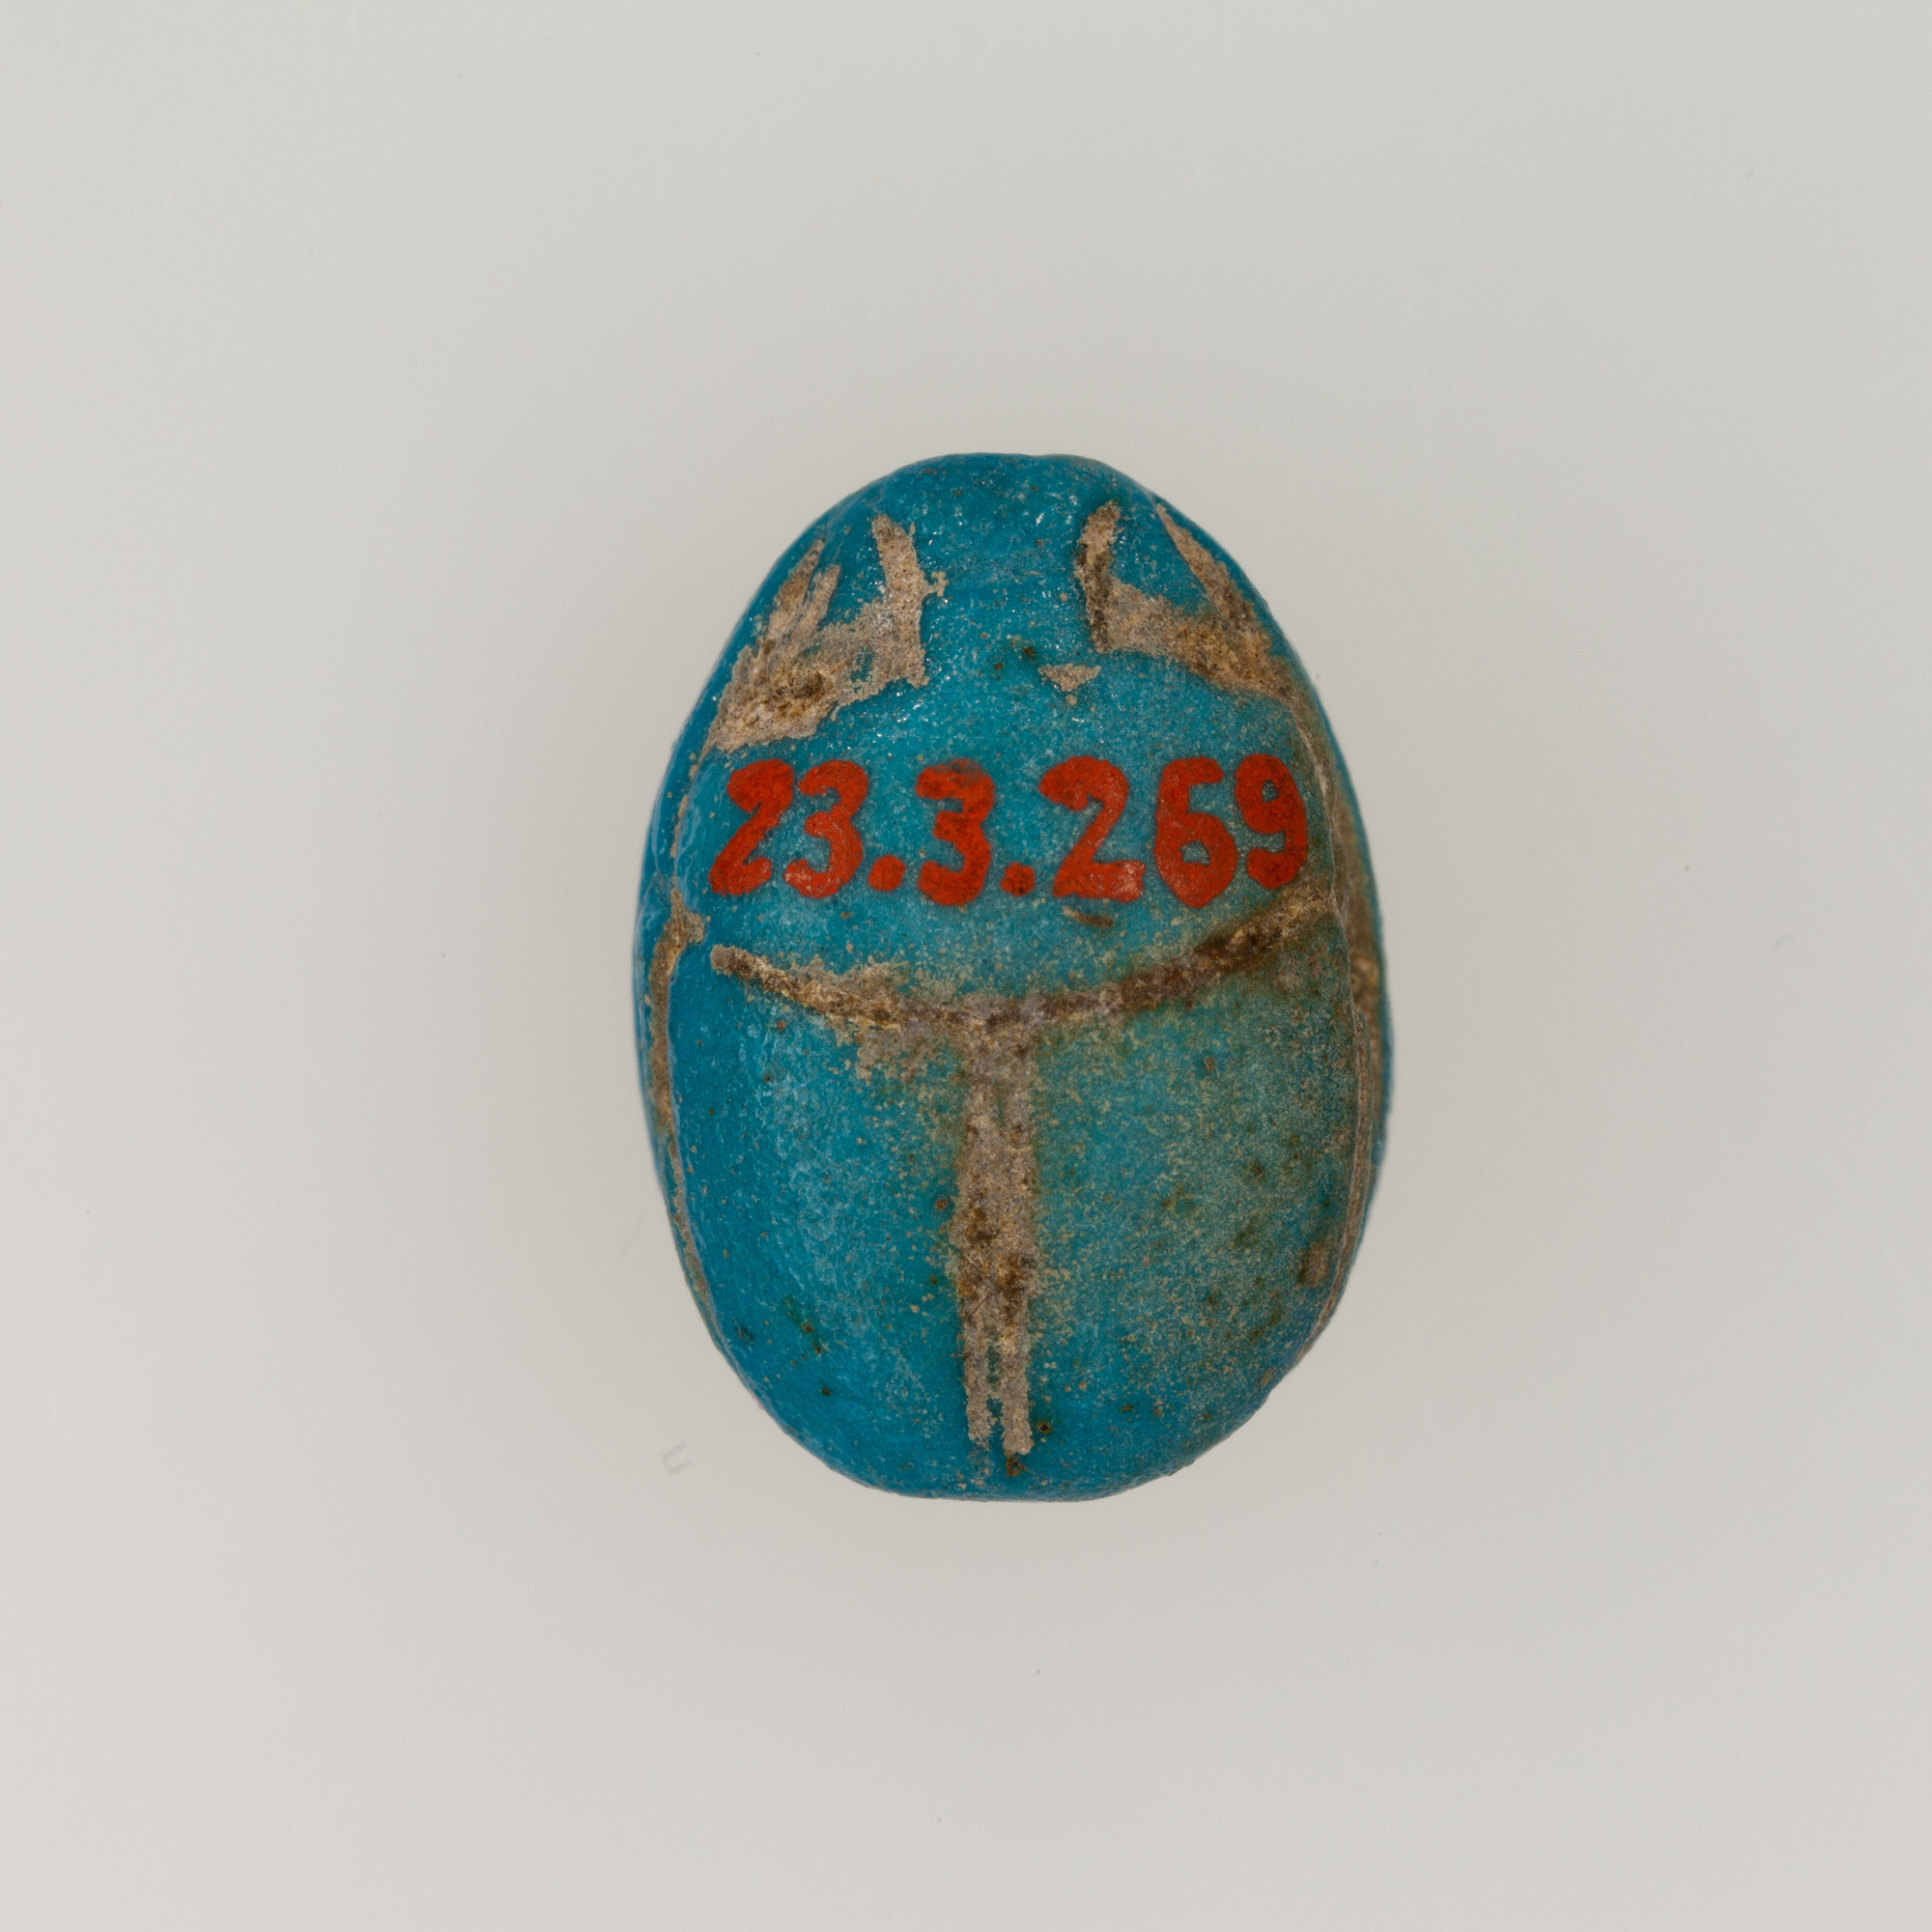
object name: scarab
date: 1479-1458 BCE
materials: faience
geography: egypt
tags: scarabs